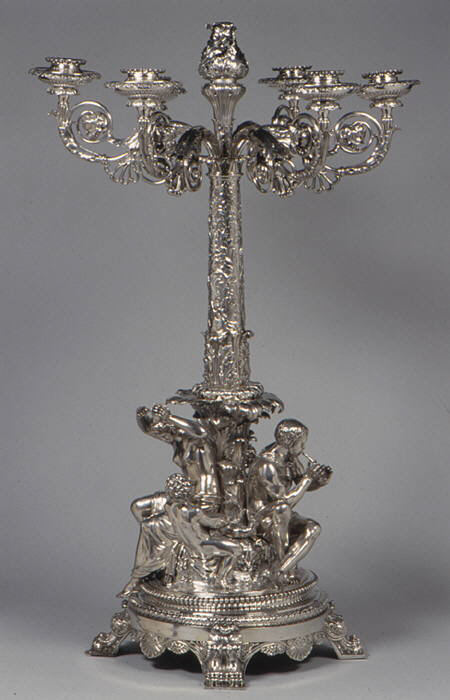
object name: candelabrum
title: Six-light candelabrum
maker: paul storr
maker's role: maker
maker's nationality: british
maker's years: 1771-1844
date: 1813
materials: silver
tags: men,women,flutes